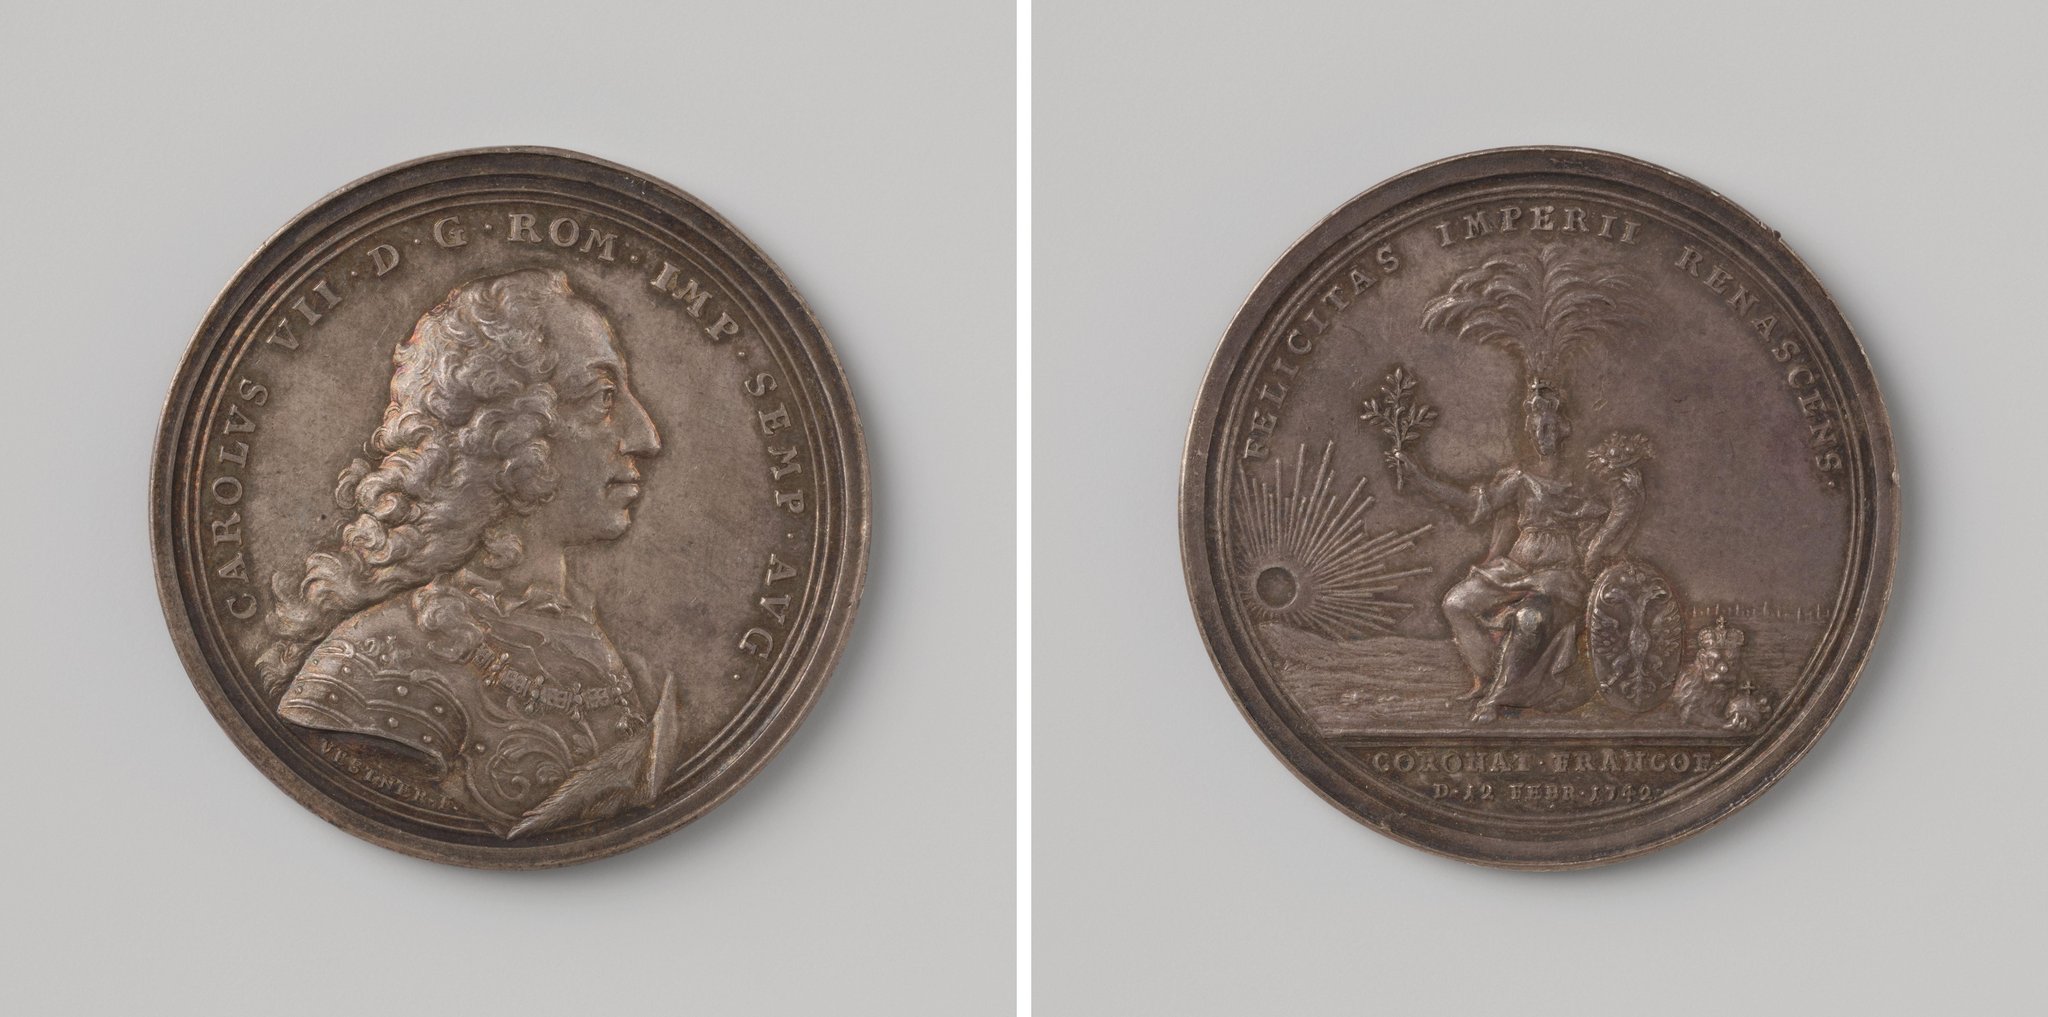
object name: history medal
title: Karel VII tot Duits keizer gekroond te Frankfurt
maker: andreas vestner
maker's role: medailleur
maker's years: 1707-1754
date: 1742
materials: silver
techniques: striking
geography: nuremberg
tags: karel vii albrecht (duits keizer)